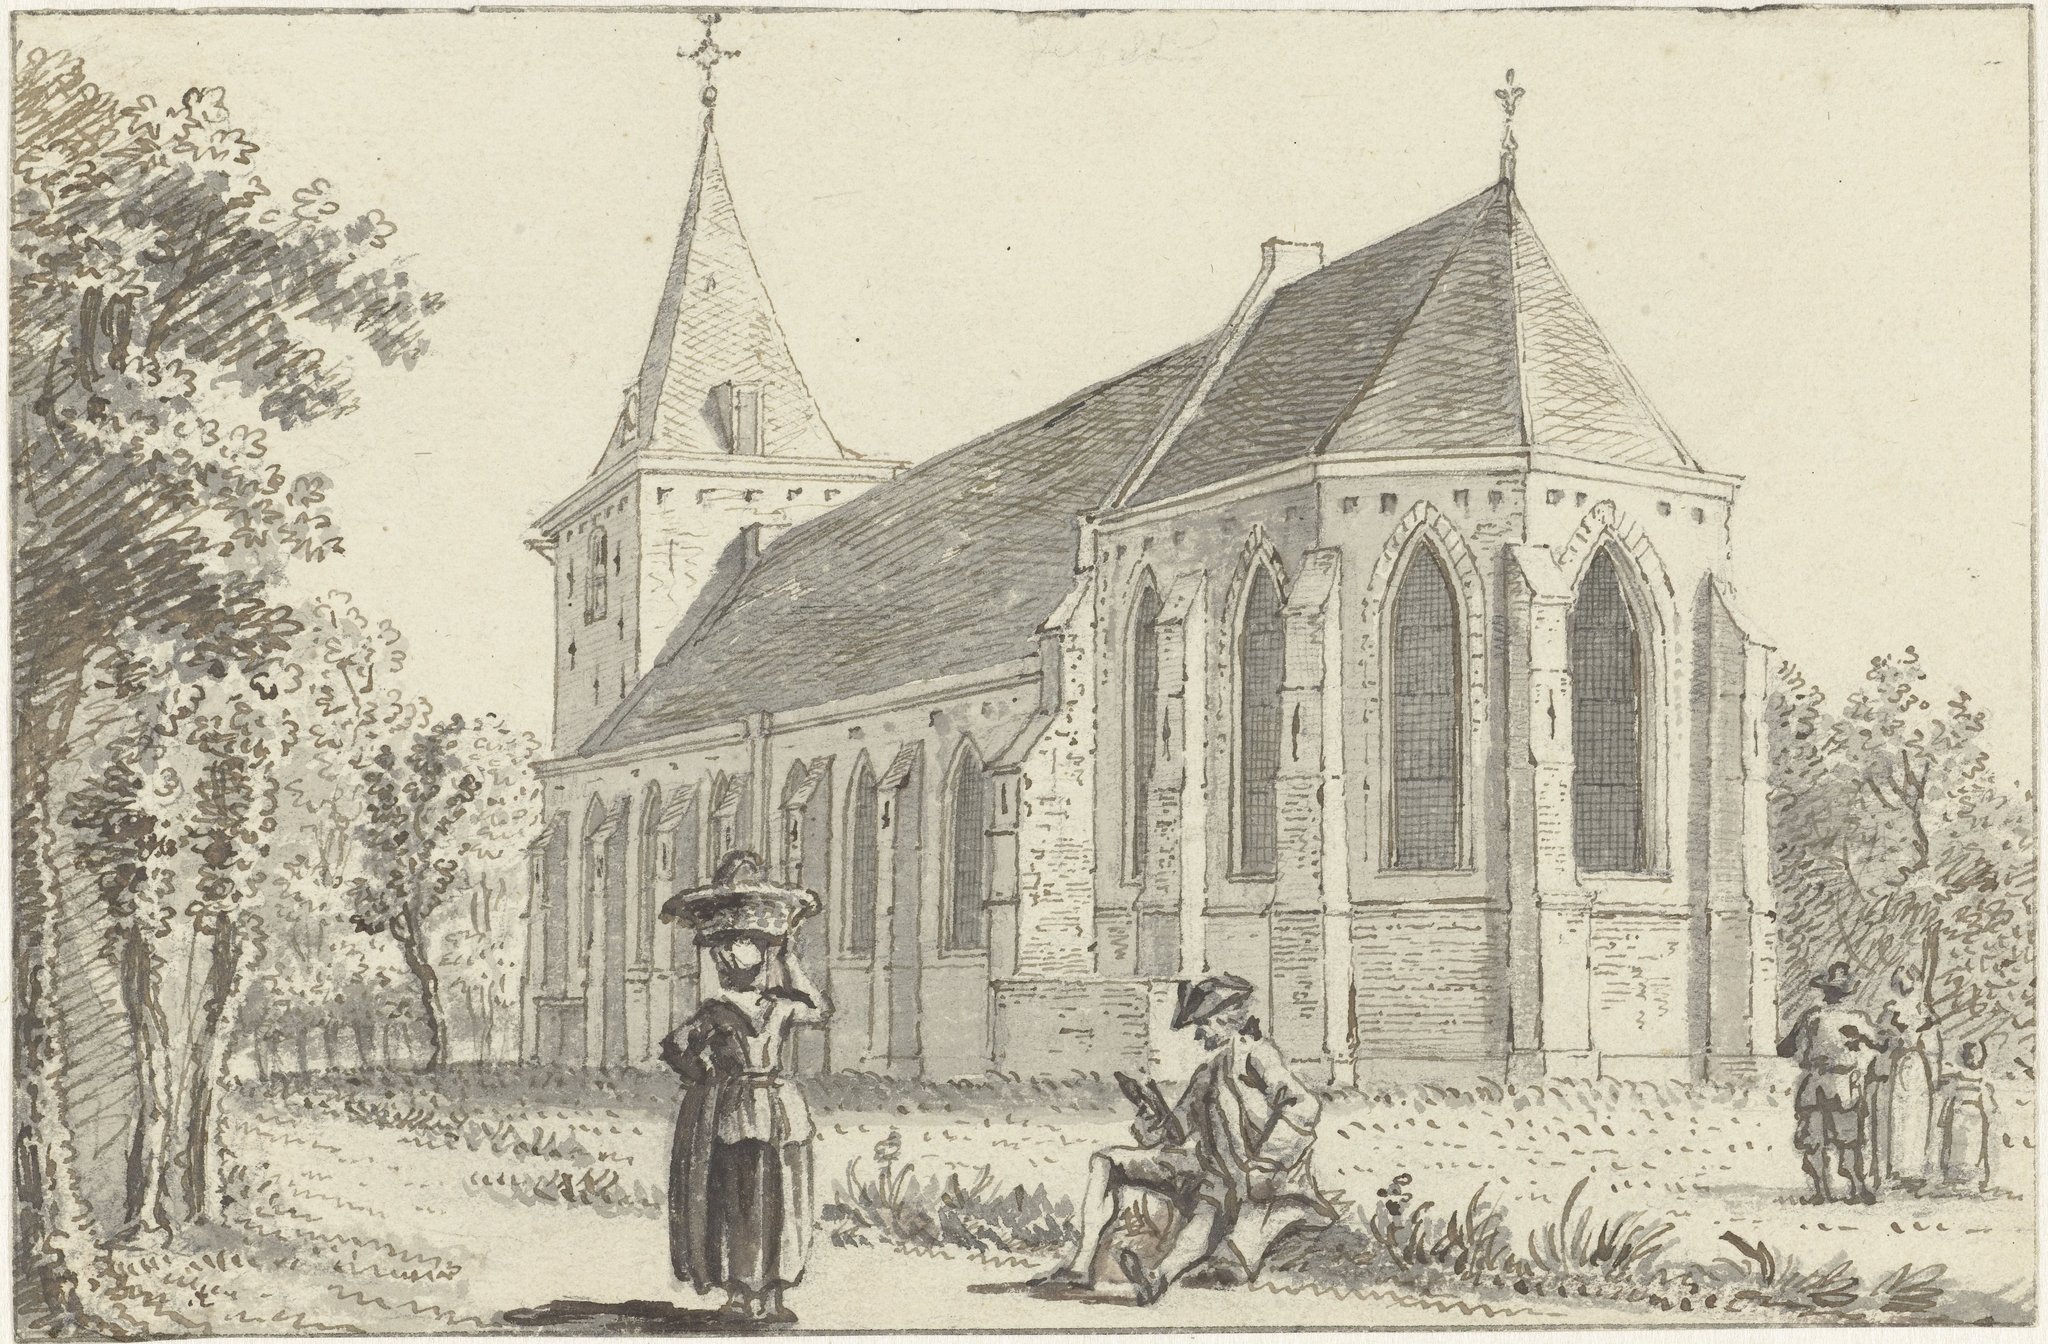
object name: drawing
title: De kerk van Zeist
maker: reinier vinkeles (i)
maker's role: draughtsman, print maker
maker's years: 1741-1816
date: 1751-1816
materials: ink, paper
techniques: brush, pen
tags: church (exterior), zeist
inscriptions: inscription: ‘De kerk te Seijst / boven Utrecht’